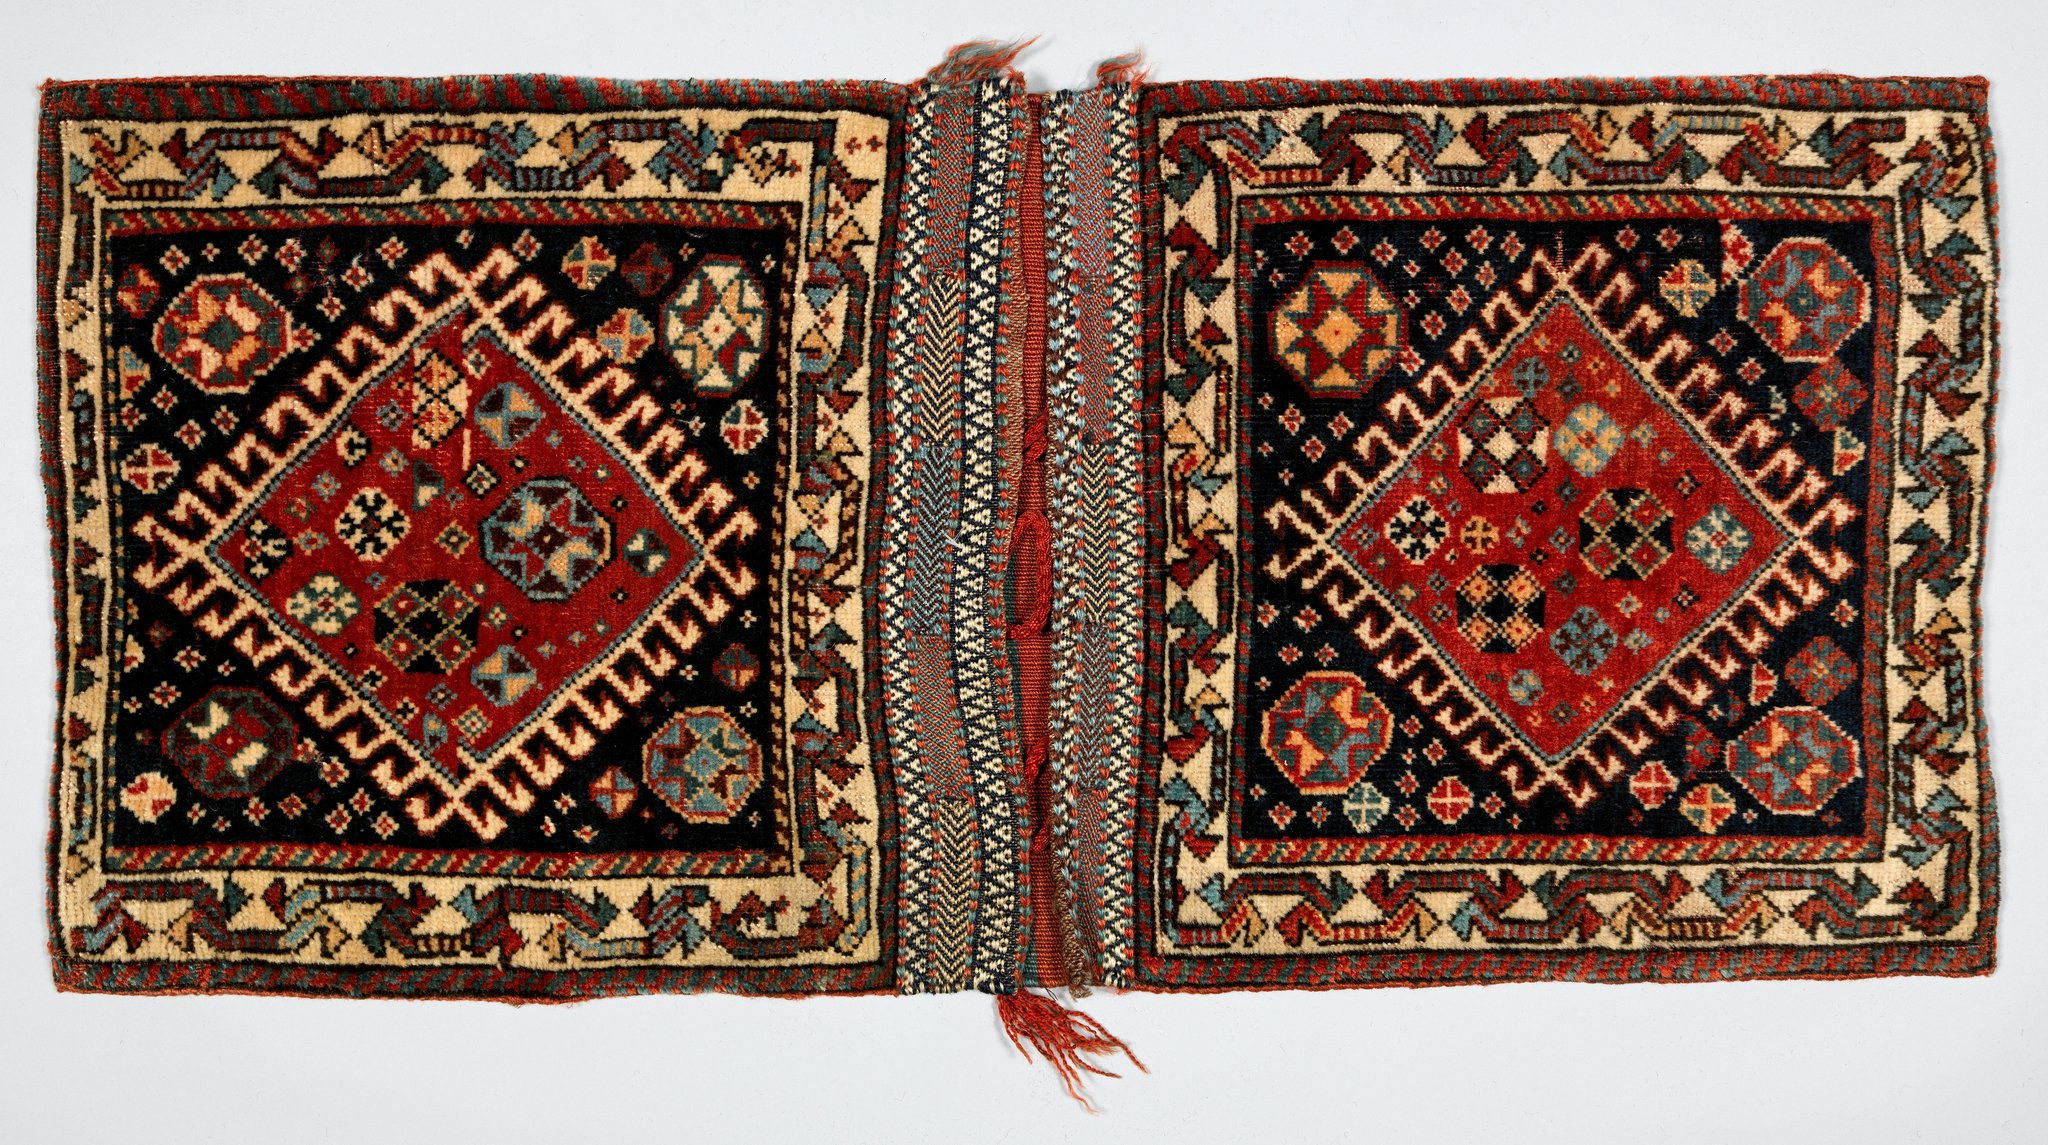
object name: saddle bag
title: Double Saddle Bag (Khorjin)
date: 1900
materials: wool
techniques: brocade, weave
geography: iran